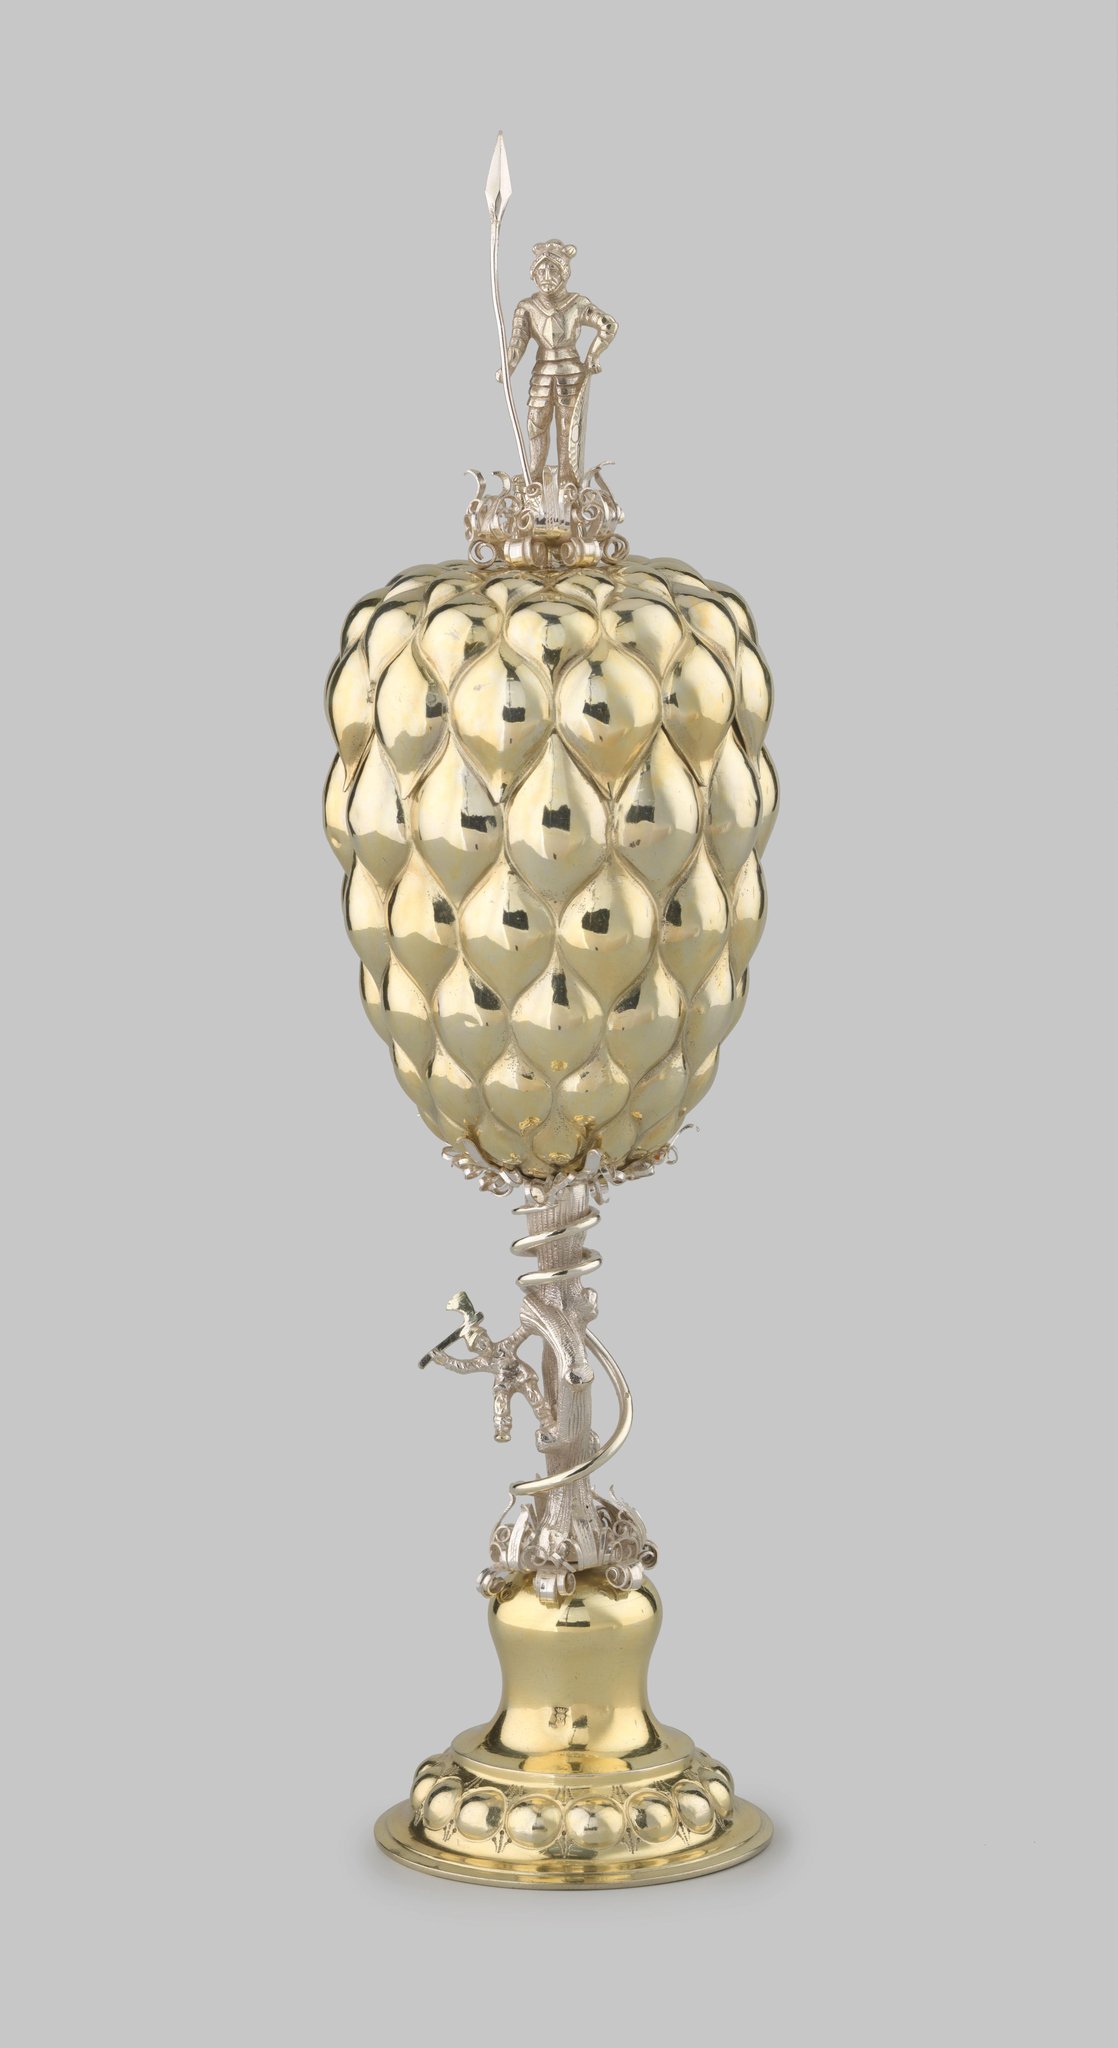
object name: goblet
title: Ananasbeker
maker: Anonymous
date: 1600-1625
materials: silver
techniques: gilding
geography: germany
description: Pineapple cup. Silver, parcel gilt. Germany, c. 1600 - 1625. On loan from the Royal Antiquarian Society.